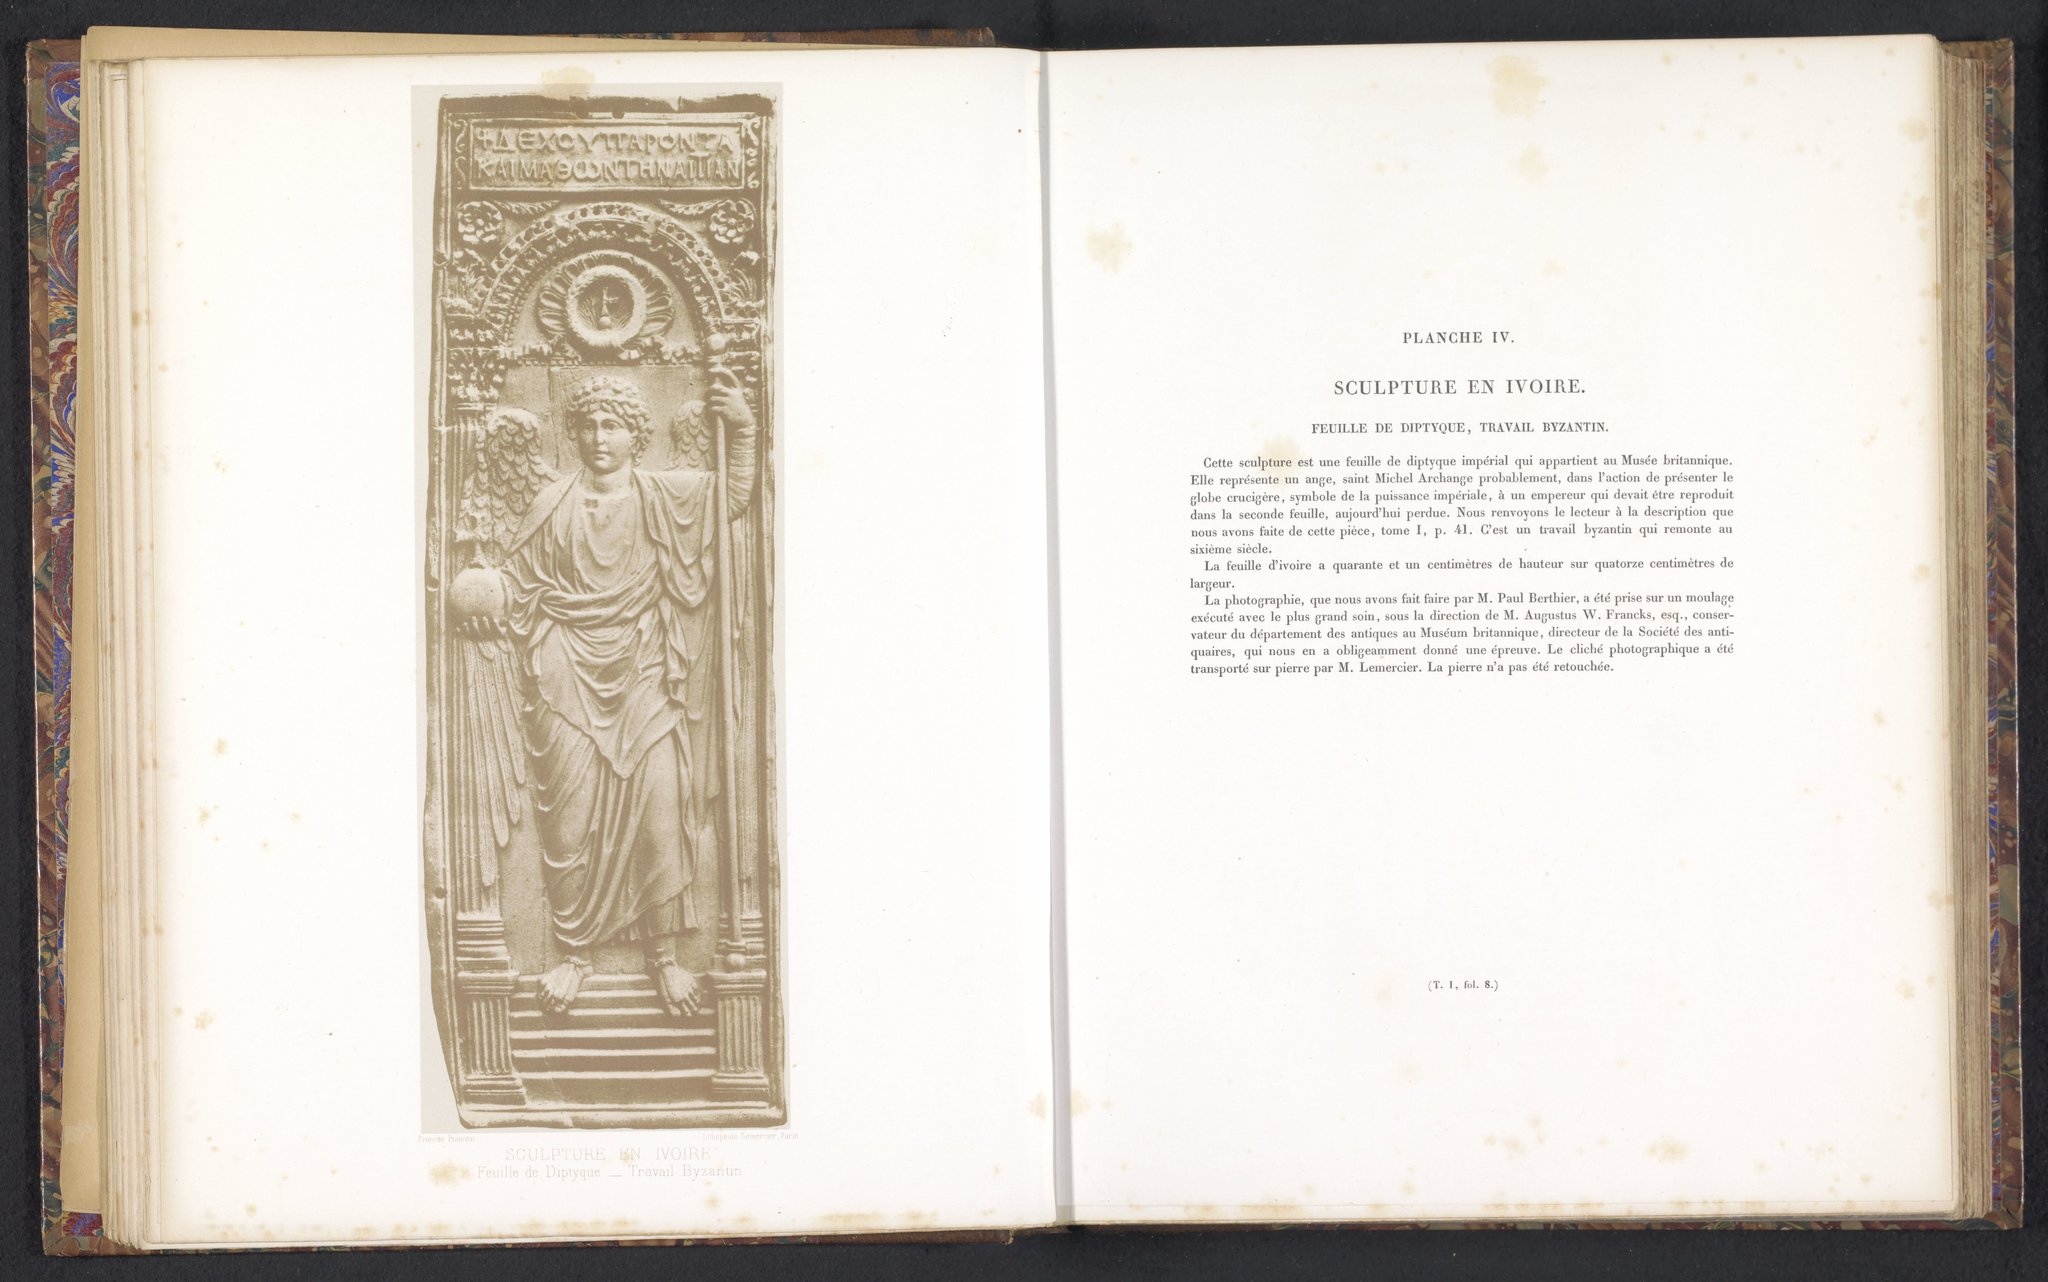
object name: photomechanical print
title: Feuille de Diptyque - Travail Byzantin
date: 1859-1864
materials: paper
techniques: photolithography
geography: paris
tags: the archangel michael (often in armour with sword or lance), angels, sculpture (+ relief ~ sculpture)